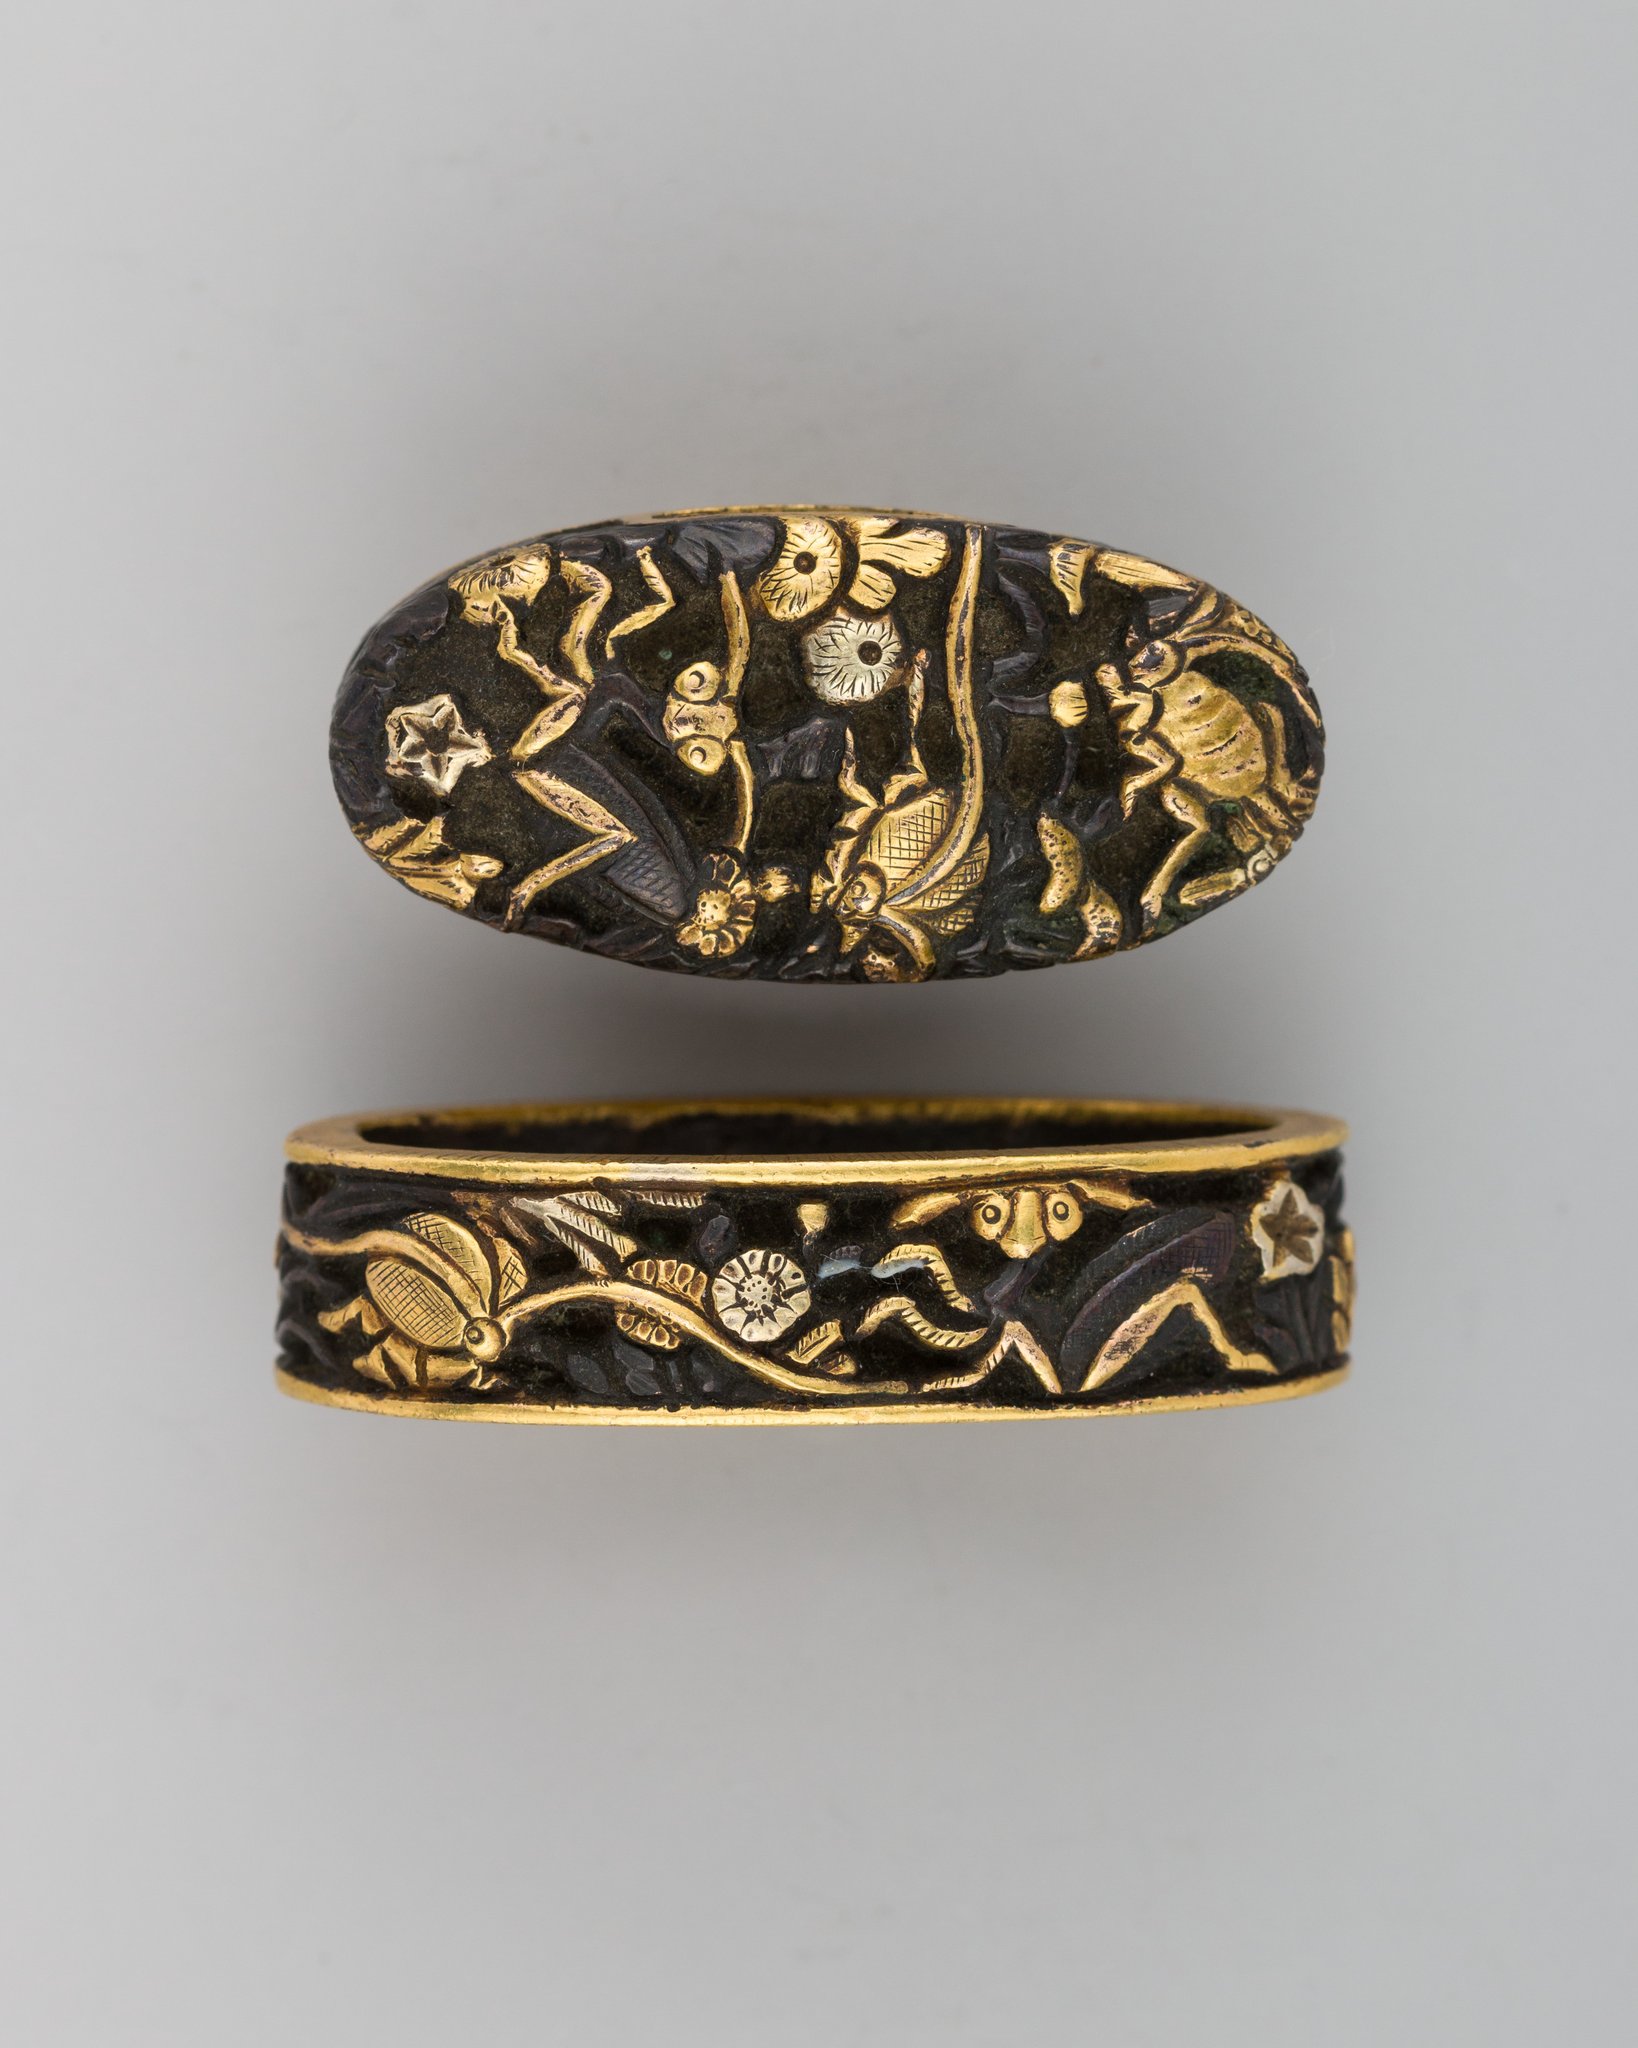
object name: sword hilt collar and pommel fuchigashira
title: Sword-Hilt Collar and Pommel (Fuchigashira)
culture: japanese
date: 1701-1900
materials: gold alloy, gold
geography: japan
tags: insects